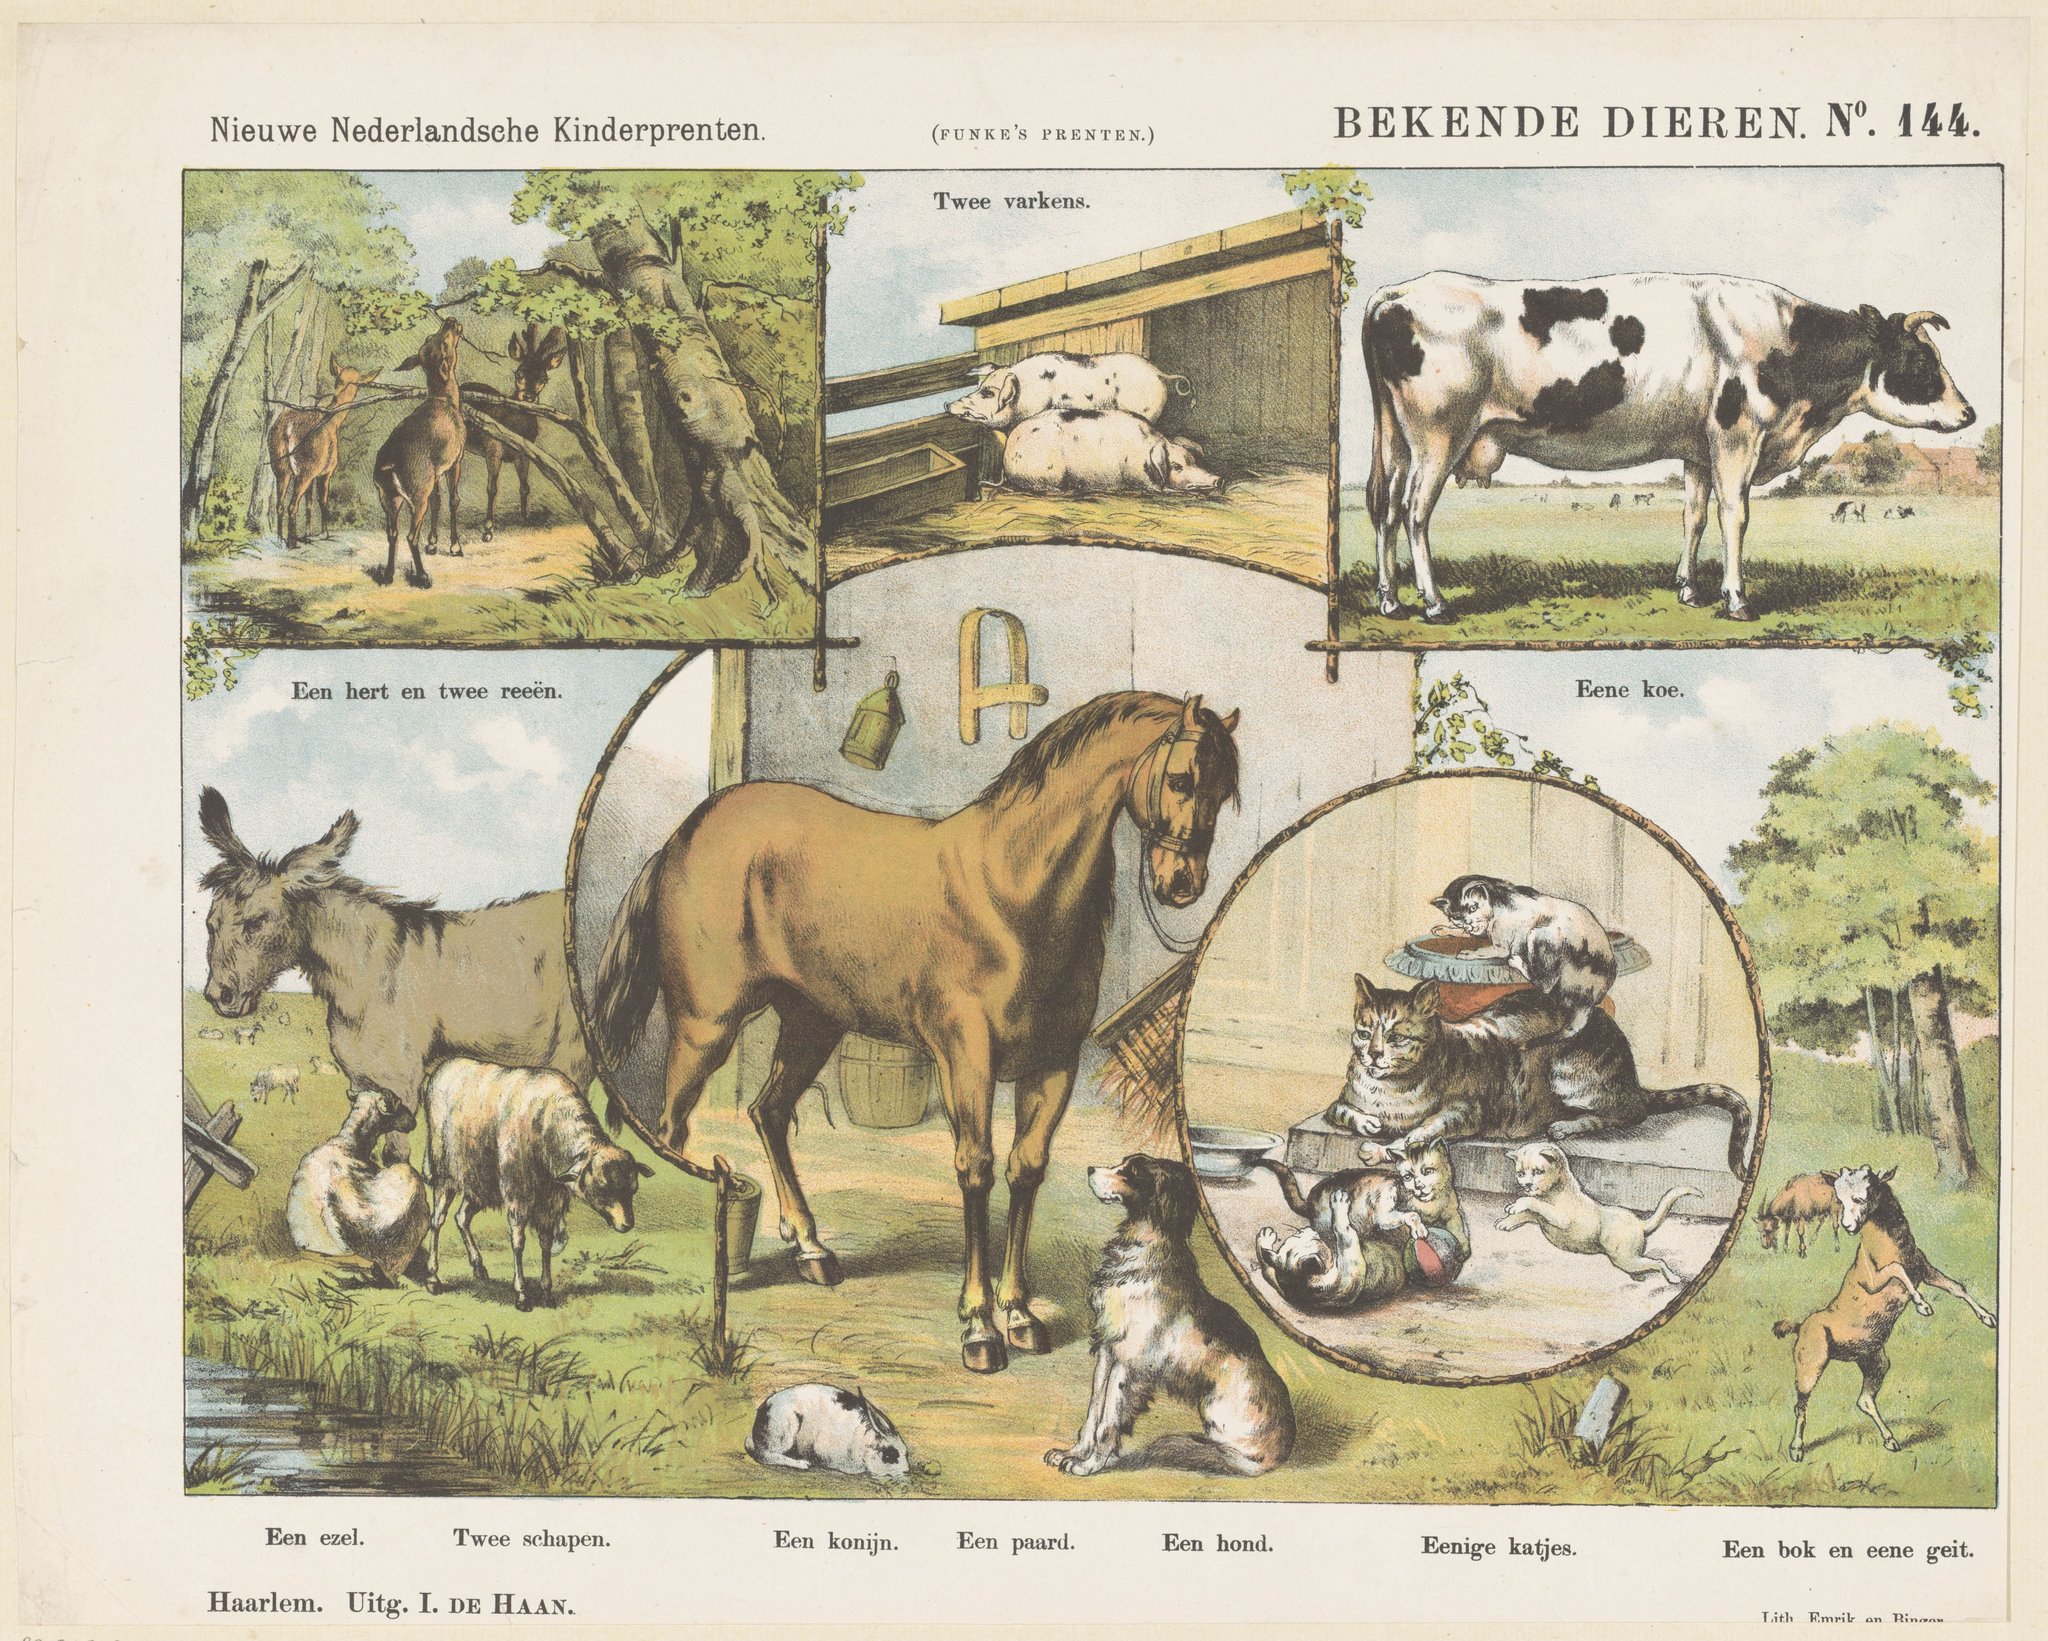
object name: print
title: Funke's prenten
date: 1875-1903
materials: paper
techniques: lithograph, letterpress printing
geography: haarlem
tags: cow, animals, cat, ass, donkey, horse, dog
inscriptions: collector's mark: Lugt 2760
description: Blad met 7 voorstellingen van boerderijdieren, zoals een koe, een ezel en katten. In de ondermarge onderschriften. Genummerd rechtsboven: No. 144.